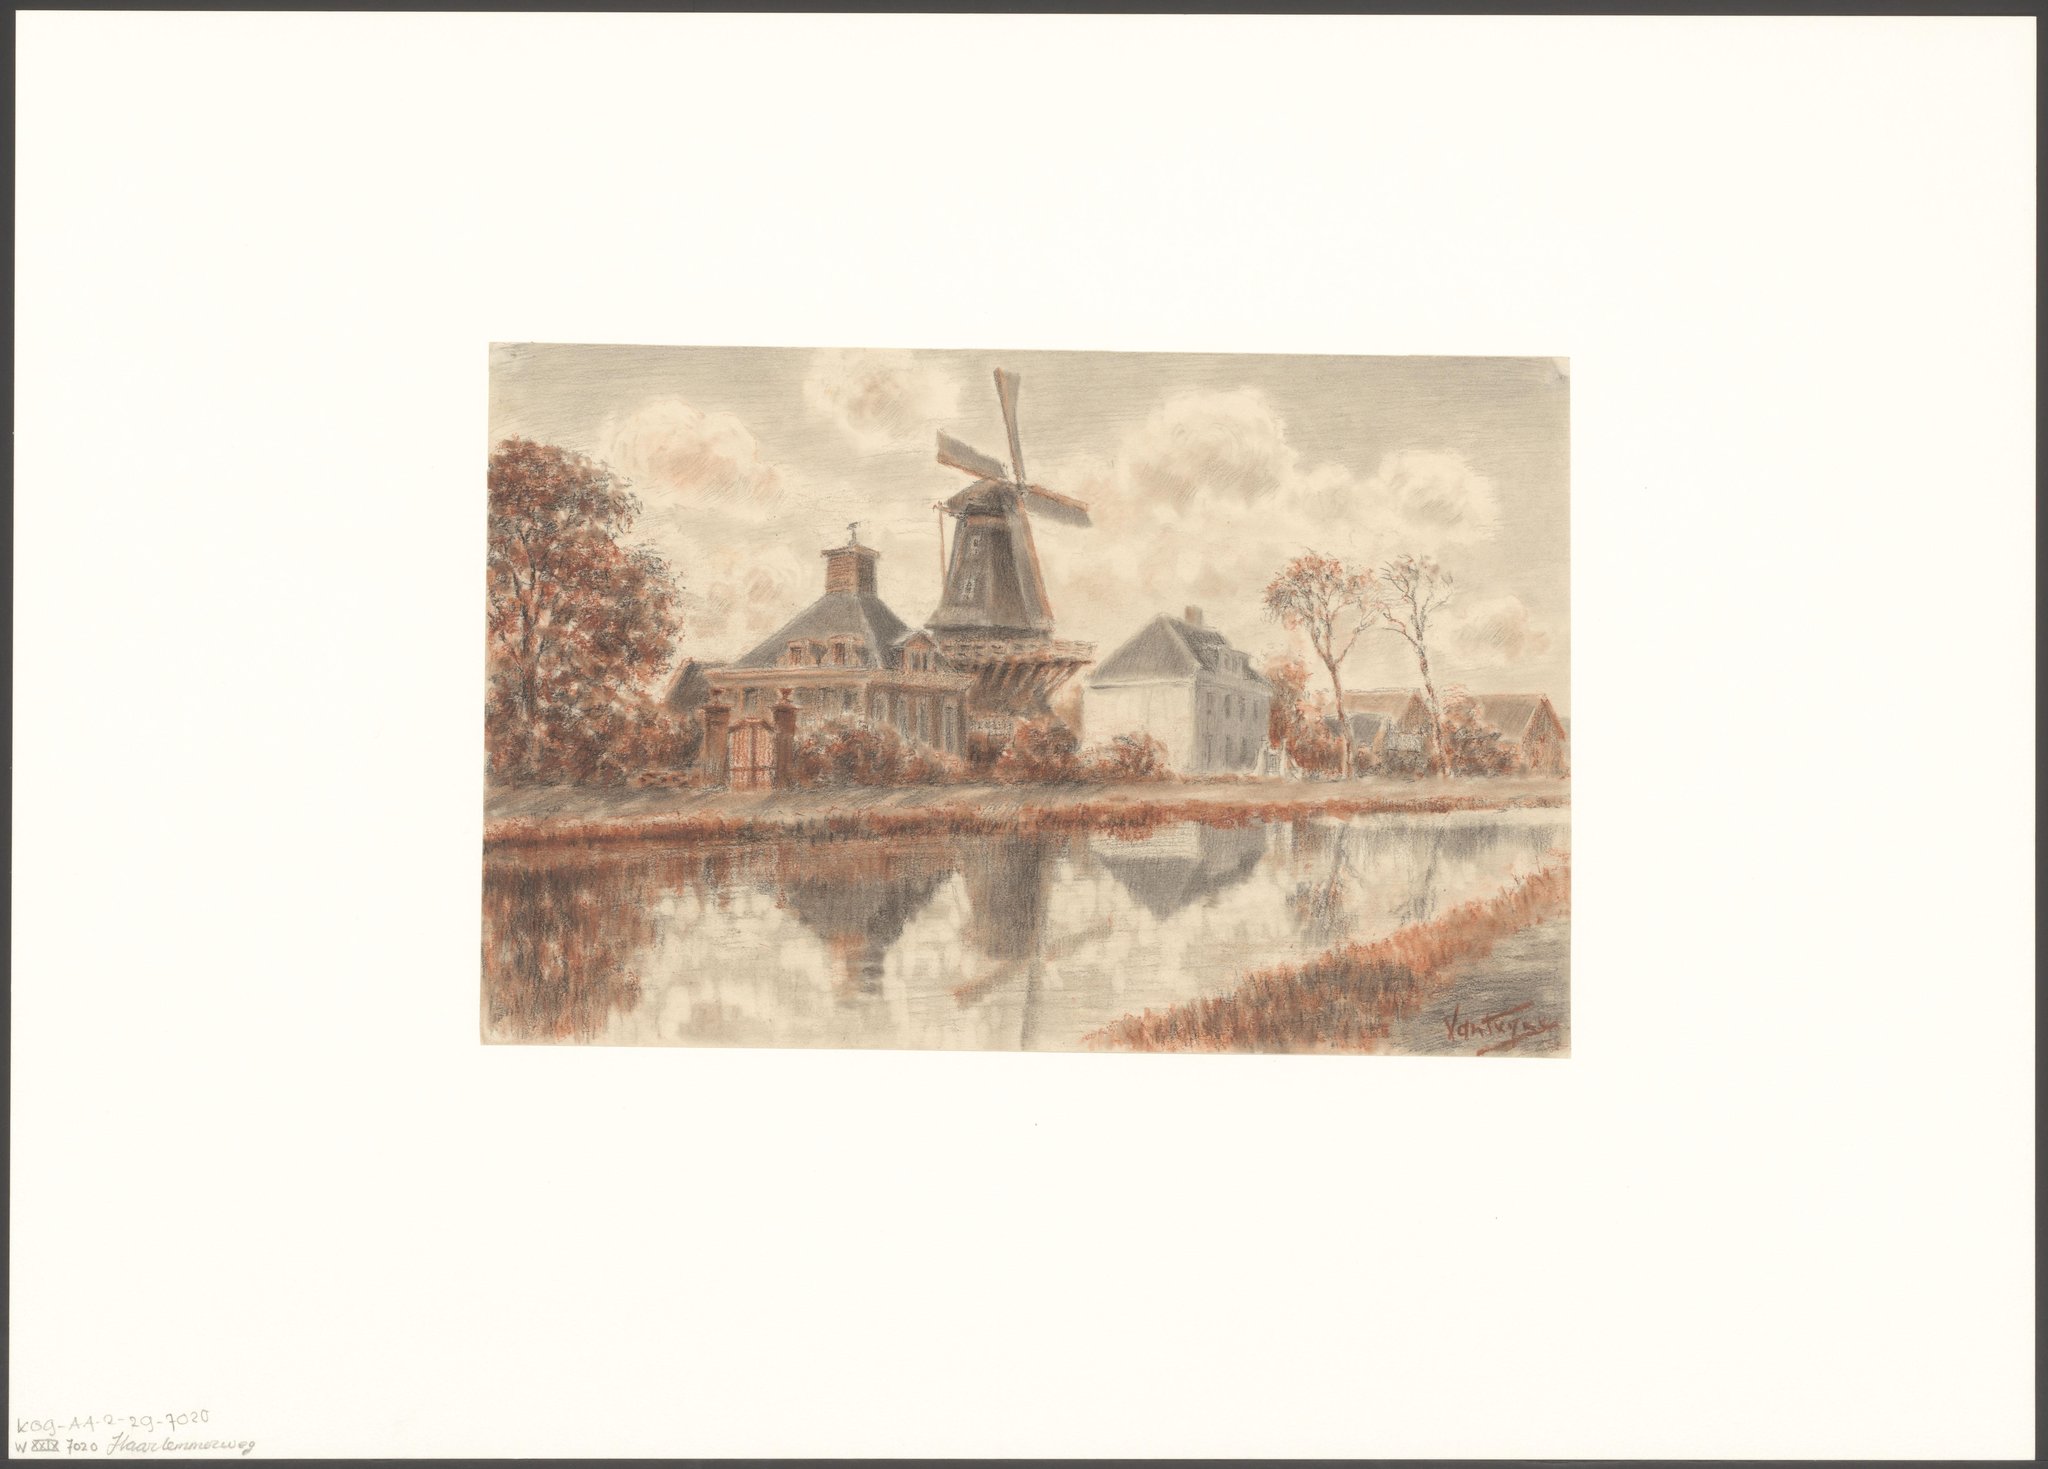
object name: drawing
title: Gezicht op molen De Bloem aan de Haarlemmerweg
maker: anthonie van teijn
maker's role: draughtsman, painter, print maker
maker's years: 1863-1943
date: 1873-1943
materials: chalk, paper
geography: amsterdam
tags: city-view in general; 'veduta', canal, windmill in landscape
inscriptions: signature: ‘VanTeyne’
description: Tekening binnen de Atlas Van Eck ingedeeld op wijknummer 29.